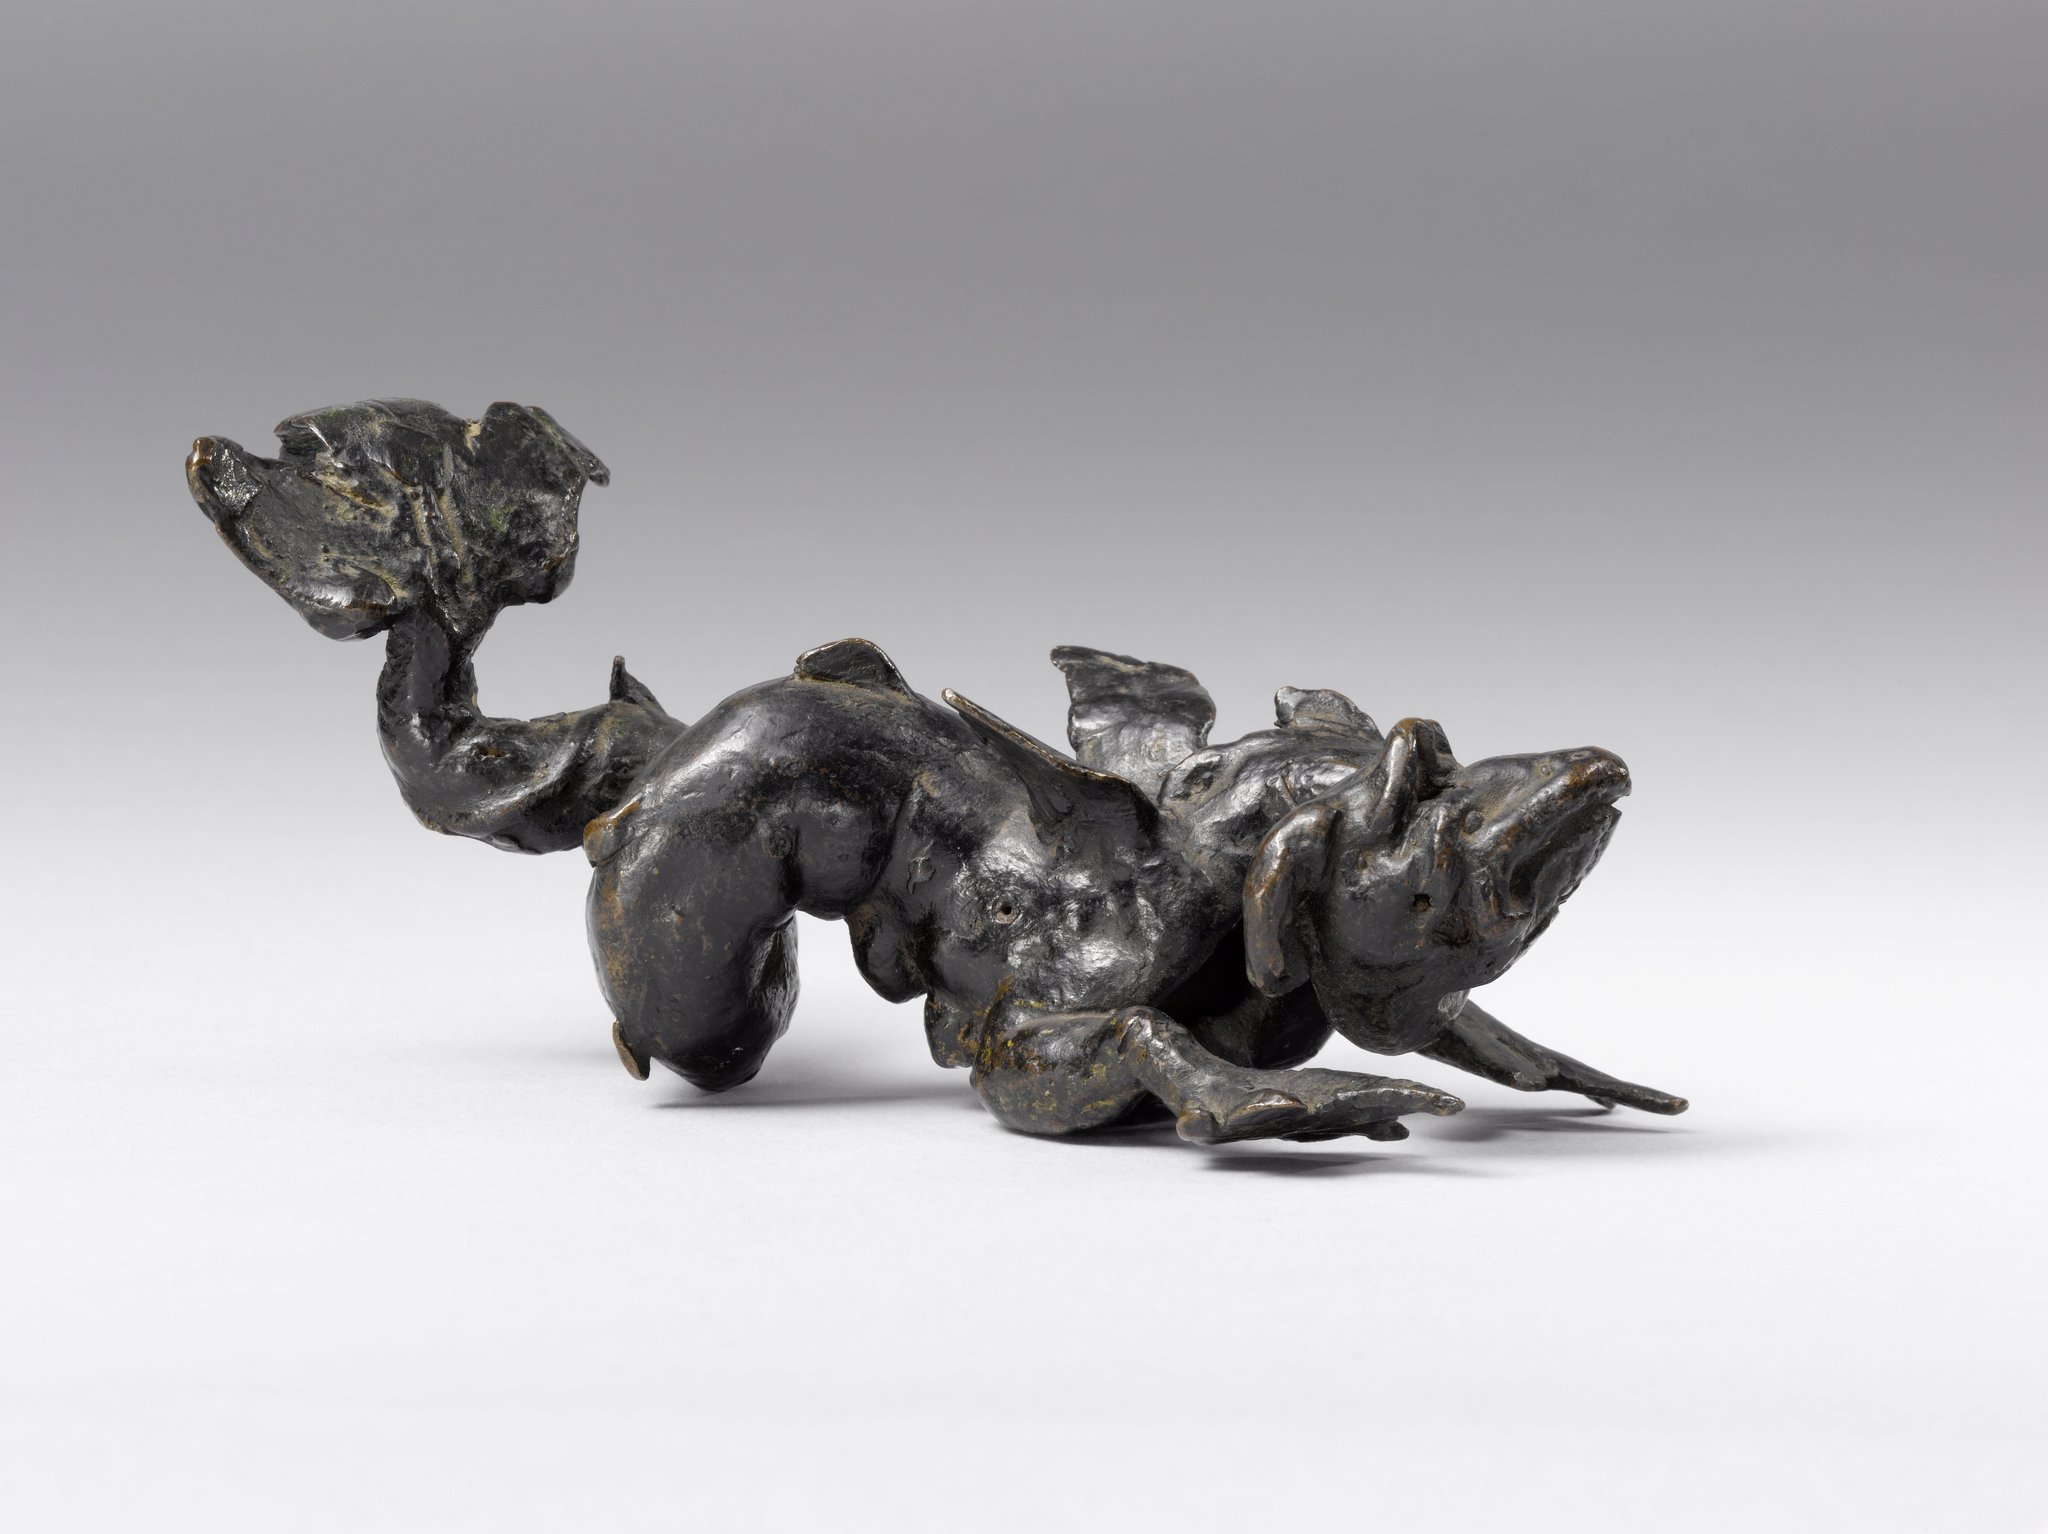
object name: sculpture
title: Gevleugelde draak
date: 1500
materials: bronze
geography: northern italy